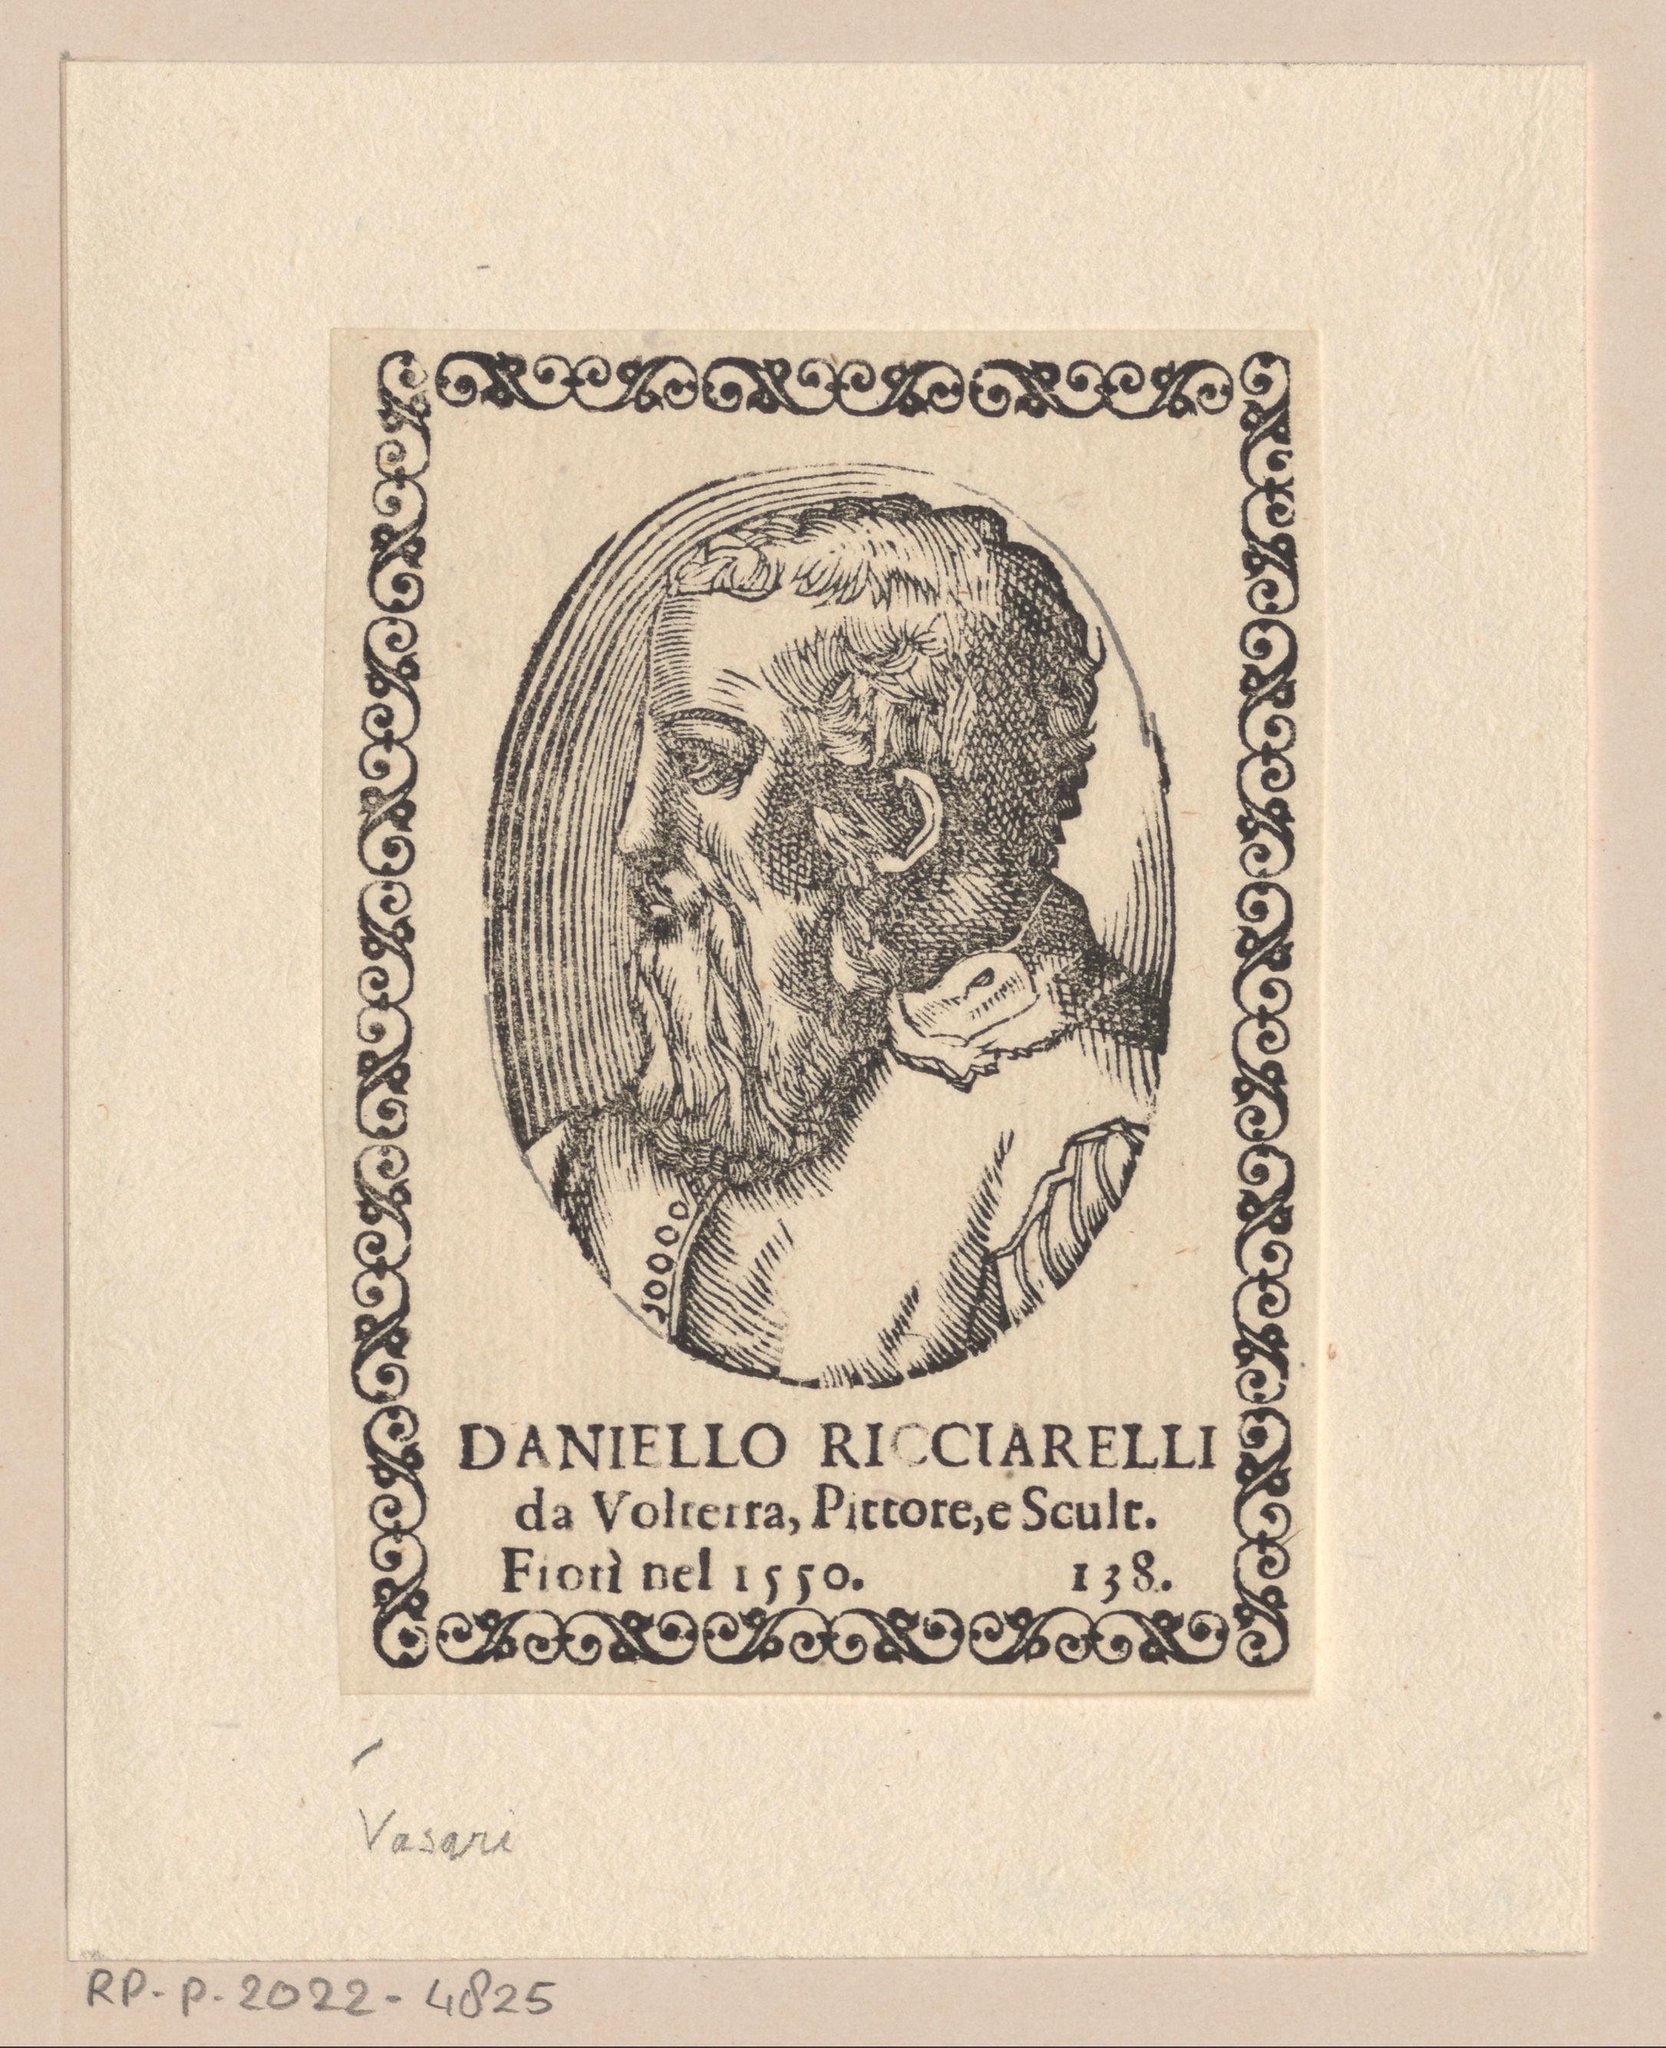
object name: print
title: Portret van Daniele da Volterra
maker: cristoforo coriolano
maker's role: print maker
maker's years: 1540-1610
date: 1568-1663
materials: paper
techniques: woodcut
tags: rome, draughtsman, daniele da volterra, portrait, self-portrait of sculptor, historical persons, portrait, self-portrait of painter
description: Prent komt waarschijnlijk uit een editie van Vasari’s Vite. De prent is met een andere omlijsting gebruikt in de editie uit 1568, en mogelijk in de edities van 1647 en 1663. Waarschijnlijk zijn de houtsneden met deze omlijsting gemaakt door Cristoforo Coriolano.